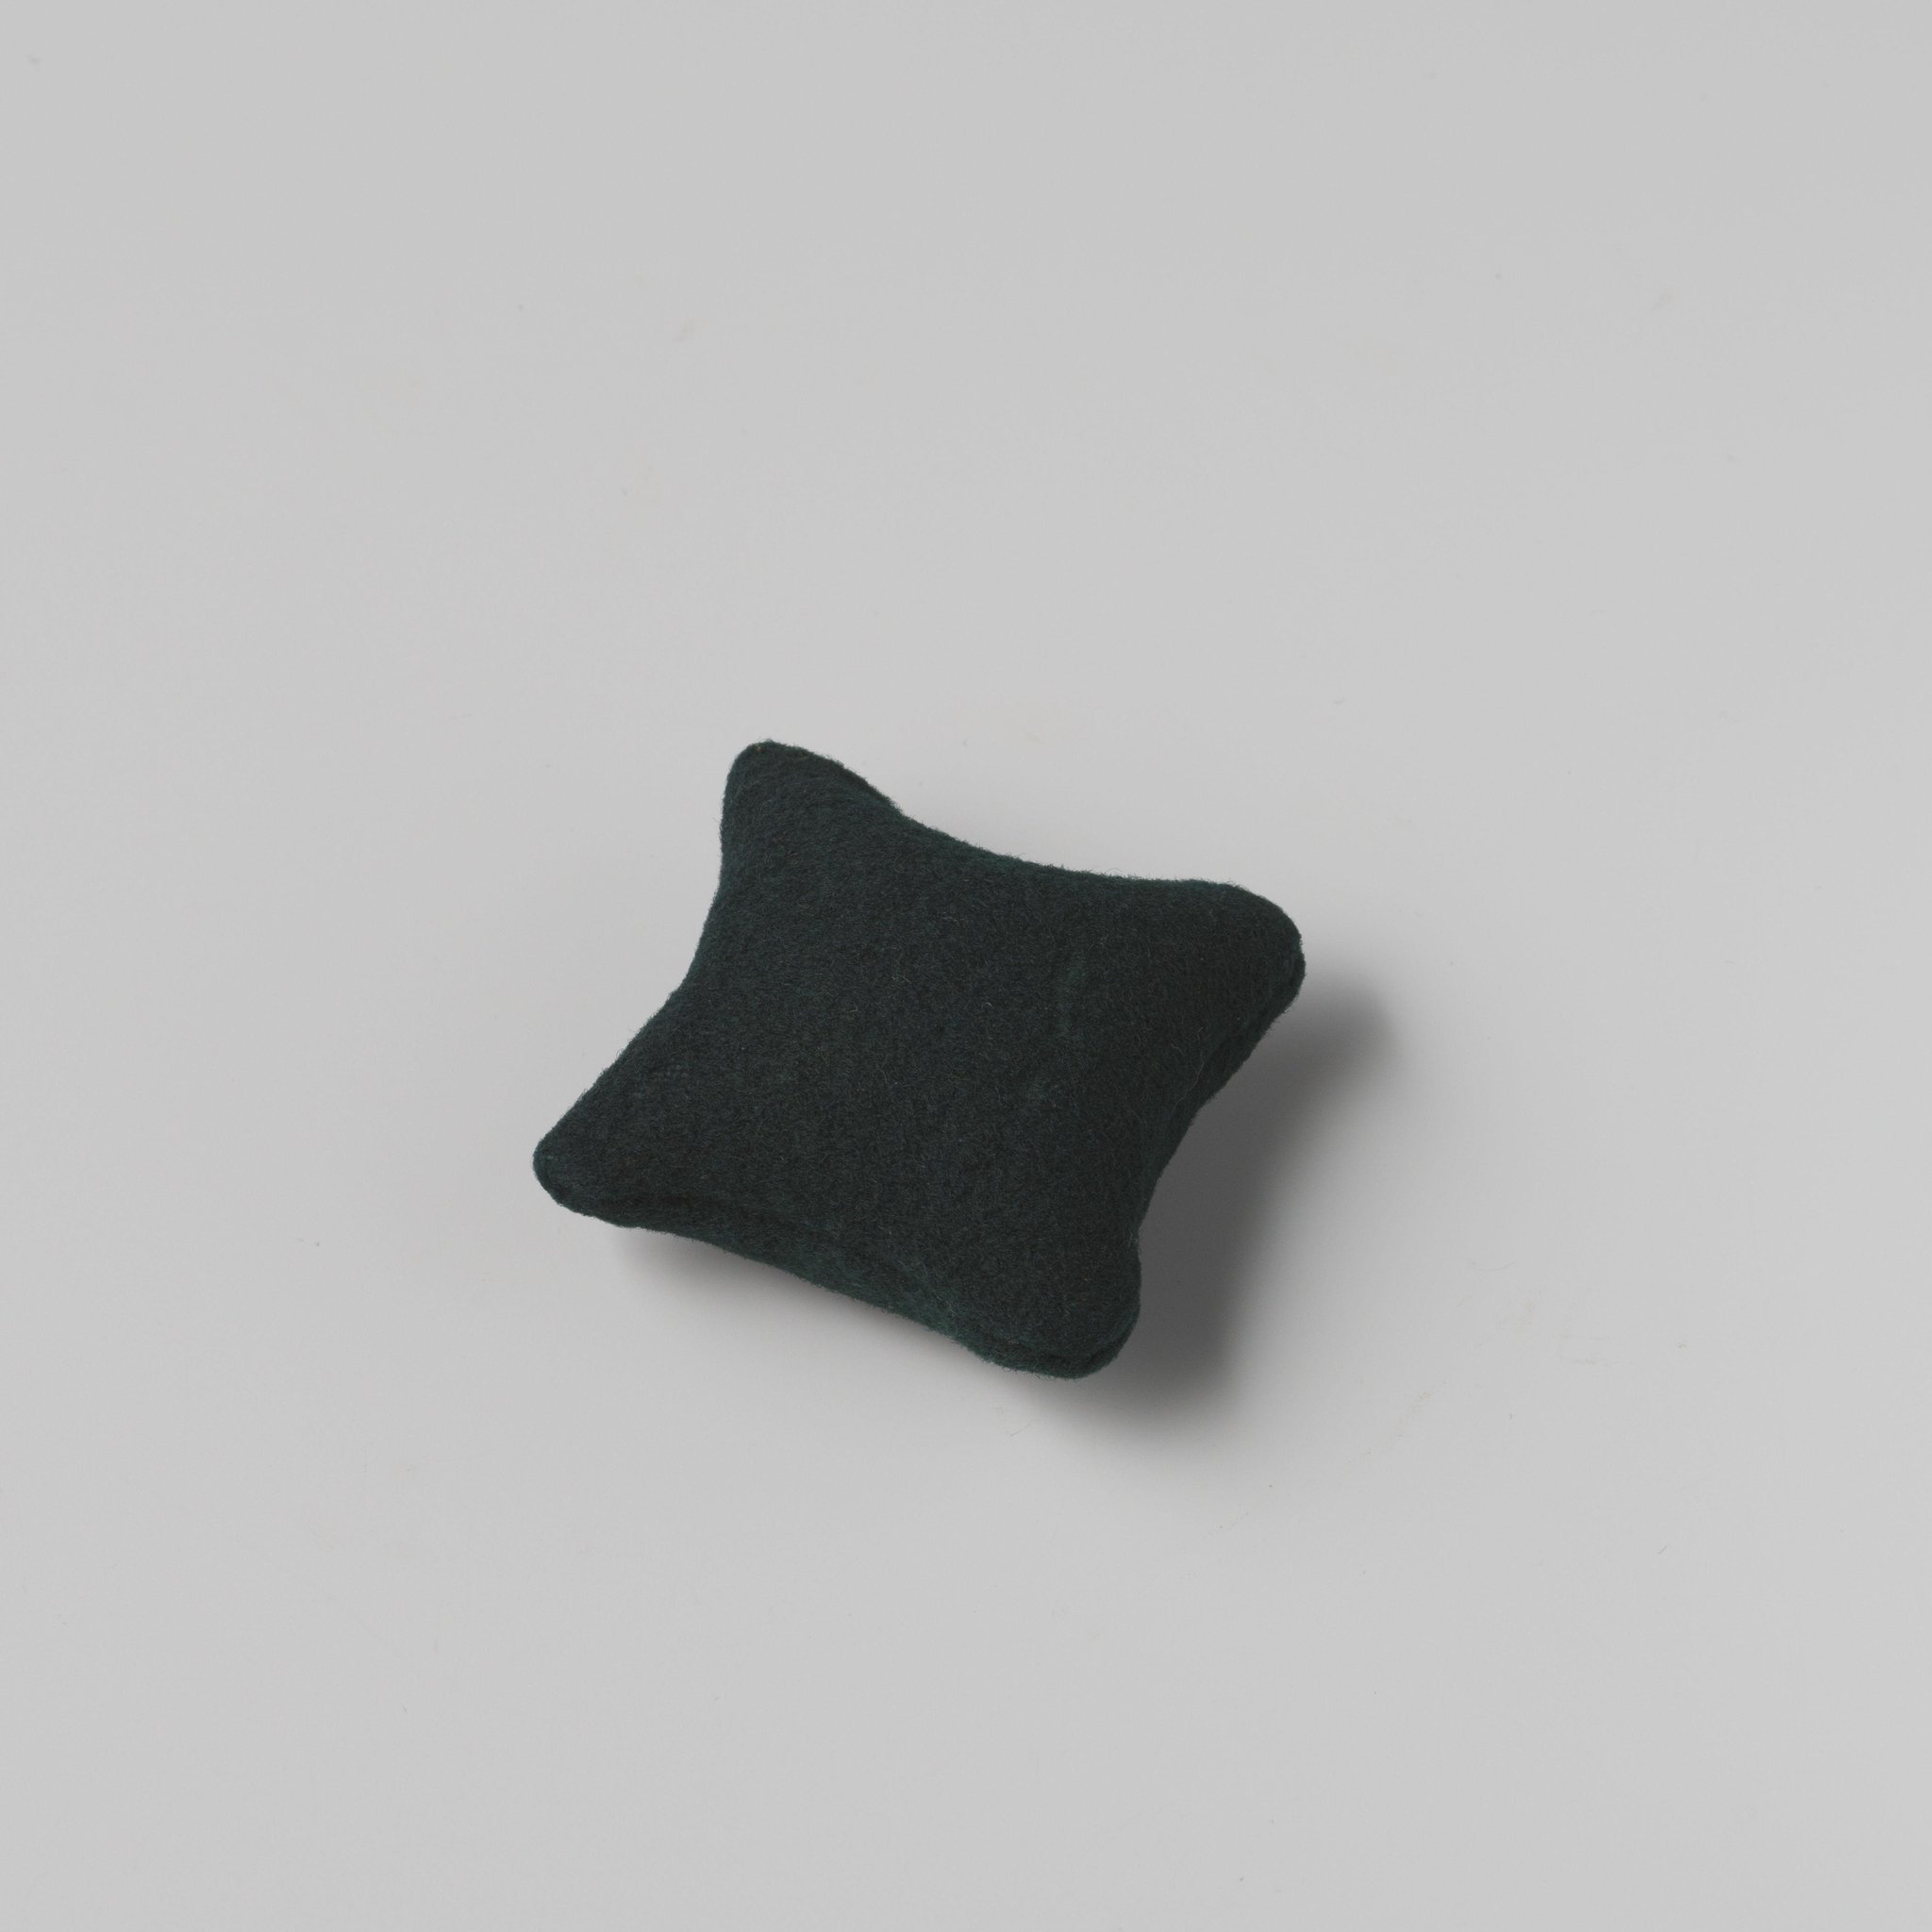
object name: stoelkussen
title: Stoelkussen van donkergroen wollen laken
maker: Anonymous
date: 1676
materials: wool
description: Stoelkussen van donkergroen wollen laken, stevig gevuld met harde vulling (zemelen?).